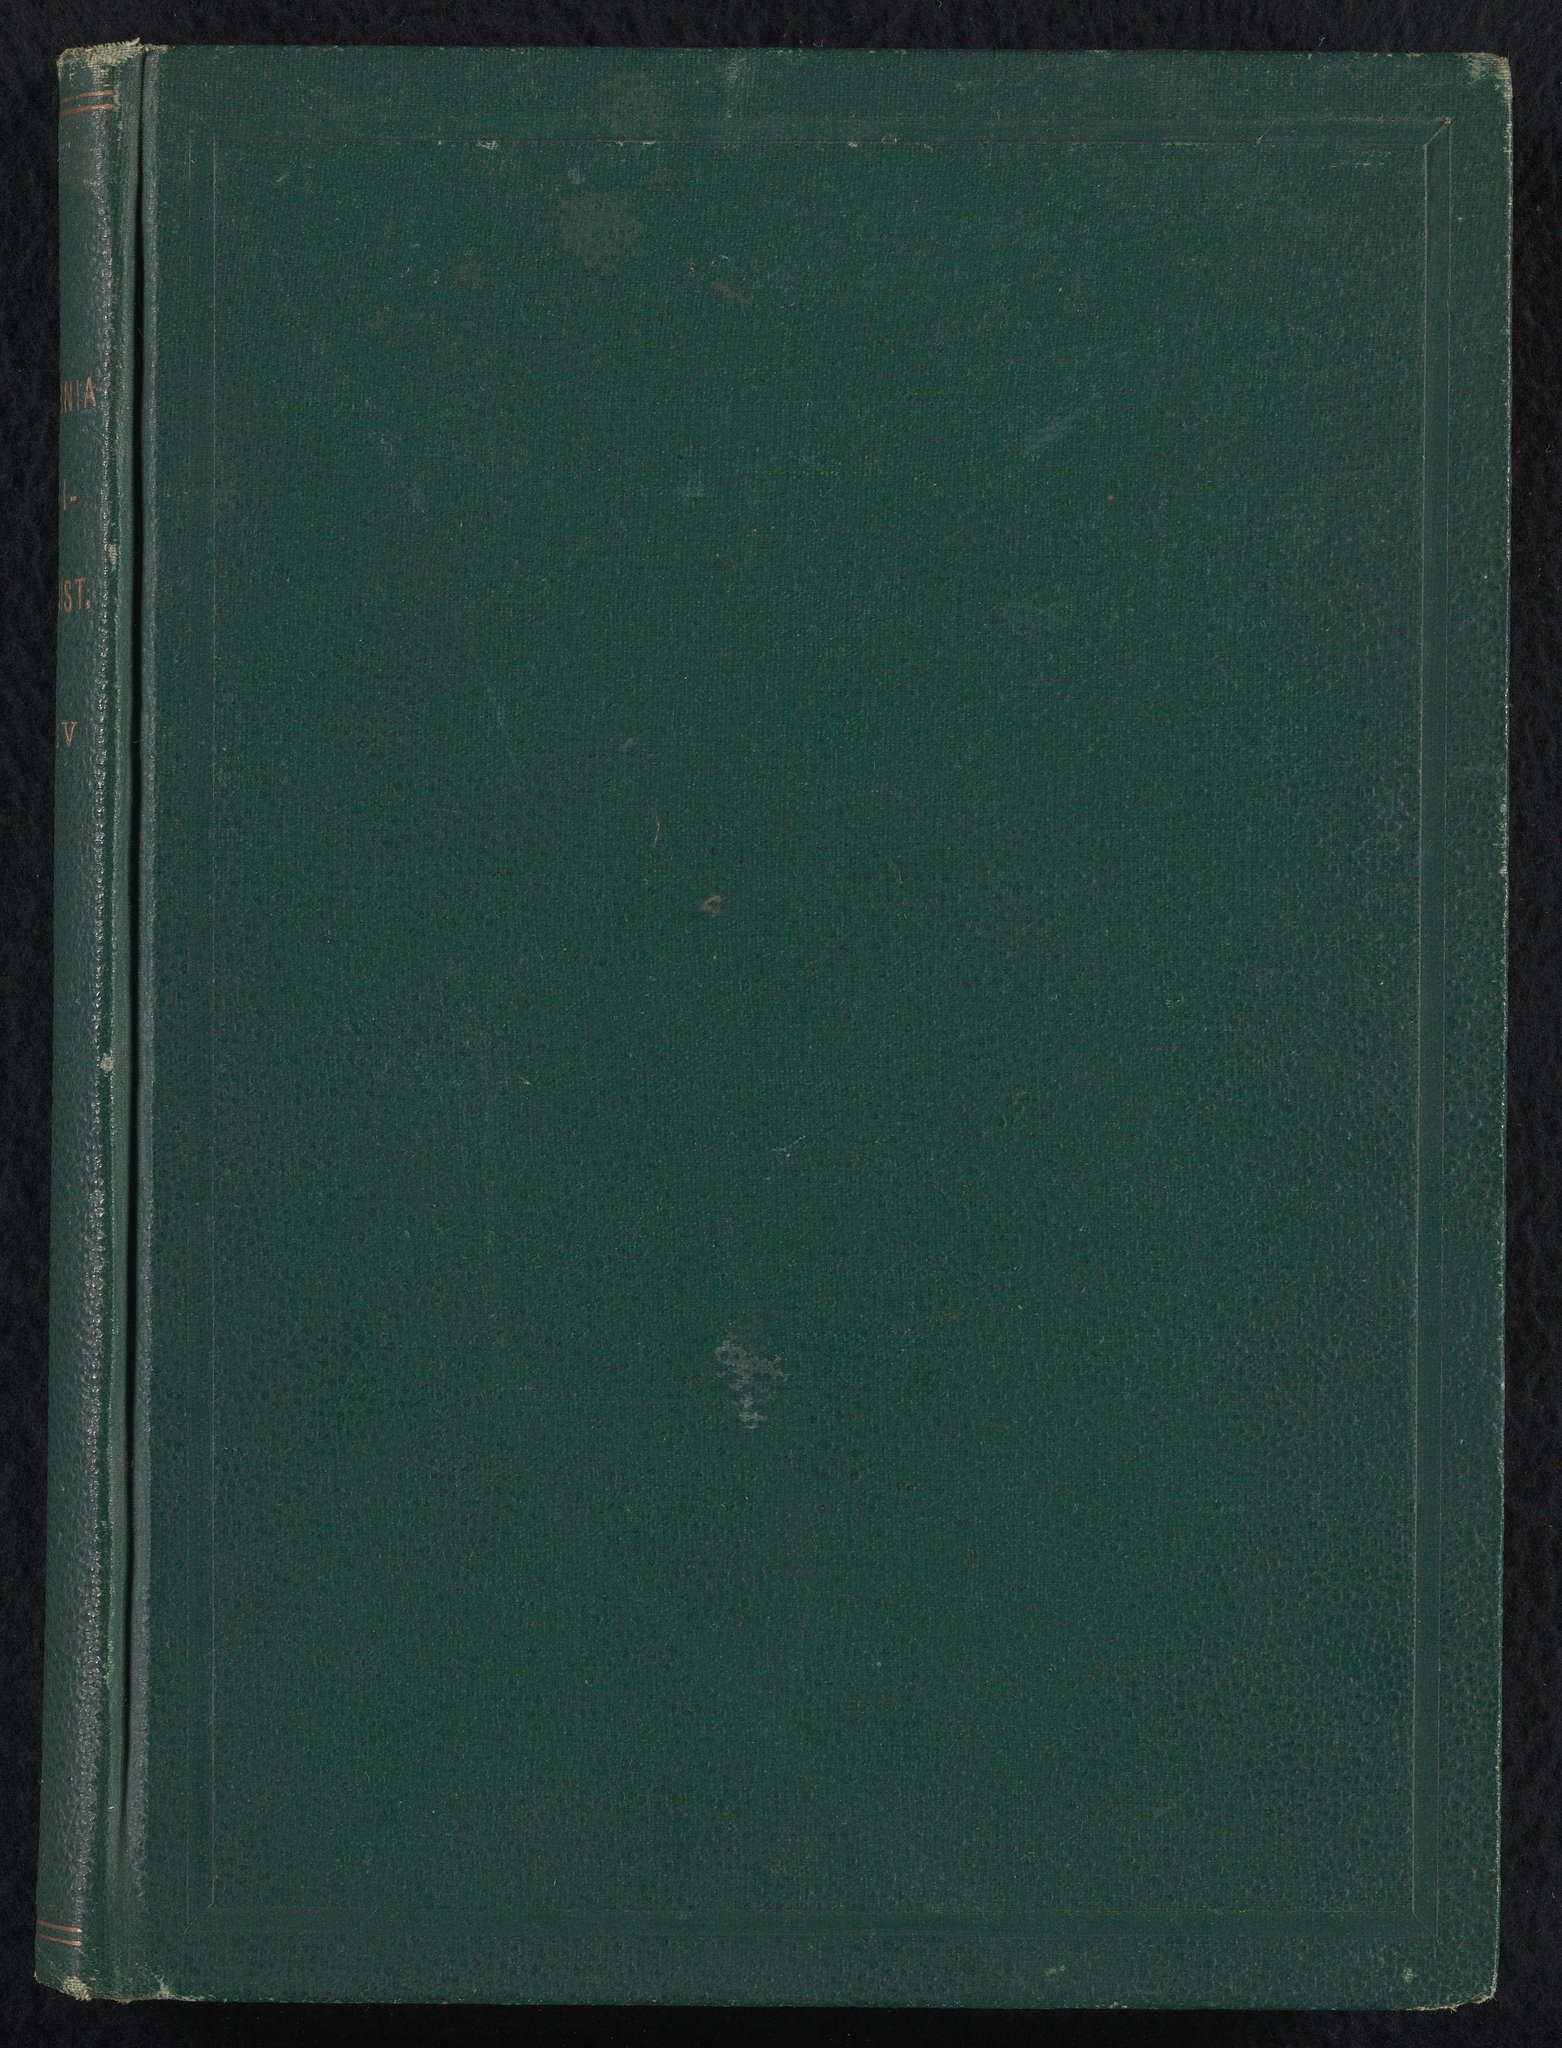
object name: book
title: The California Horticulturist and Floral Magazine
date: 1874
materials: cardboard, paper, textile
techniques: albumen print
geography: san francisco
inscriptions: date: ‘APR/ 2002’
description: Boek met één foto van Woodward's Gardens in San Fransisco.